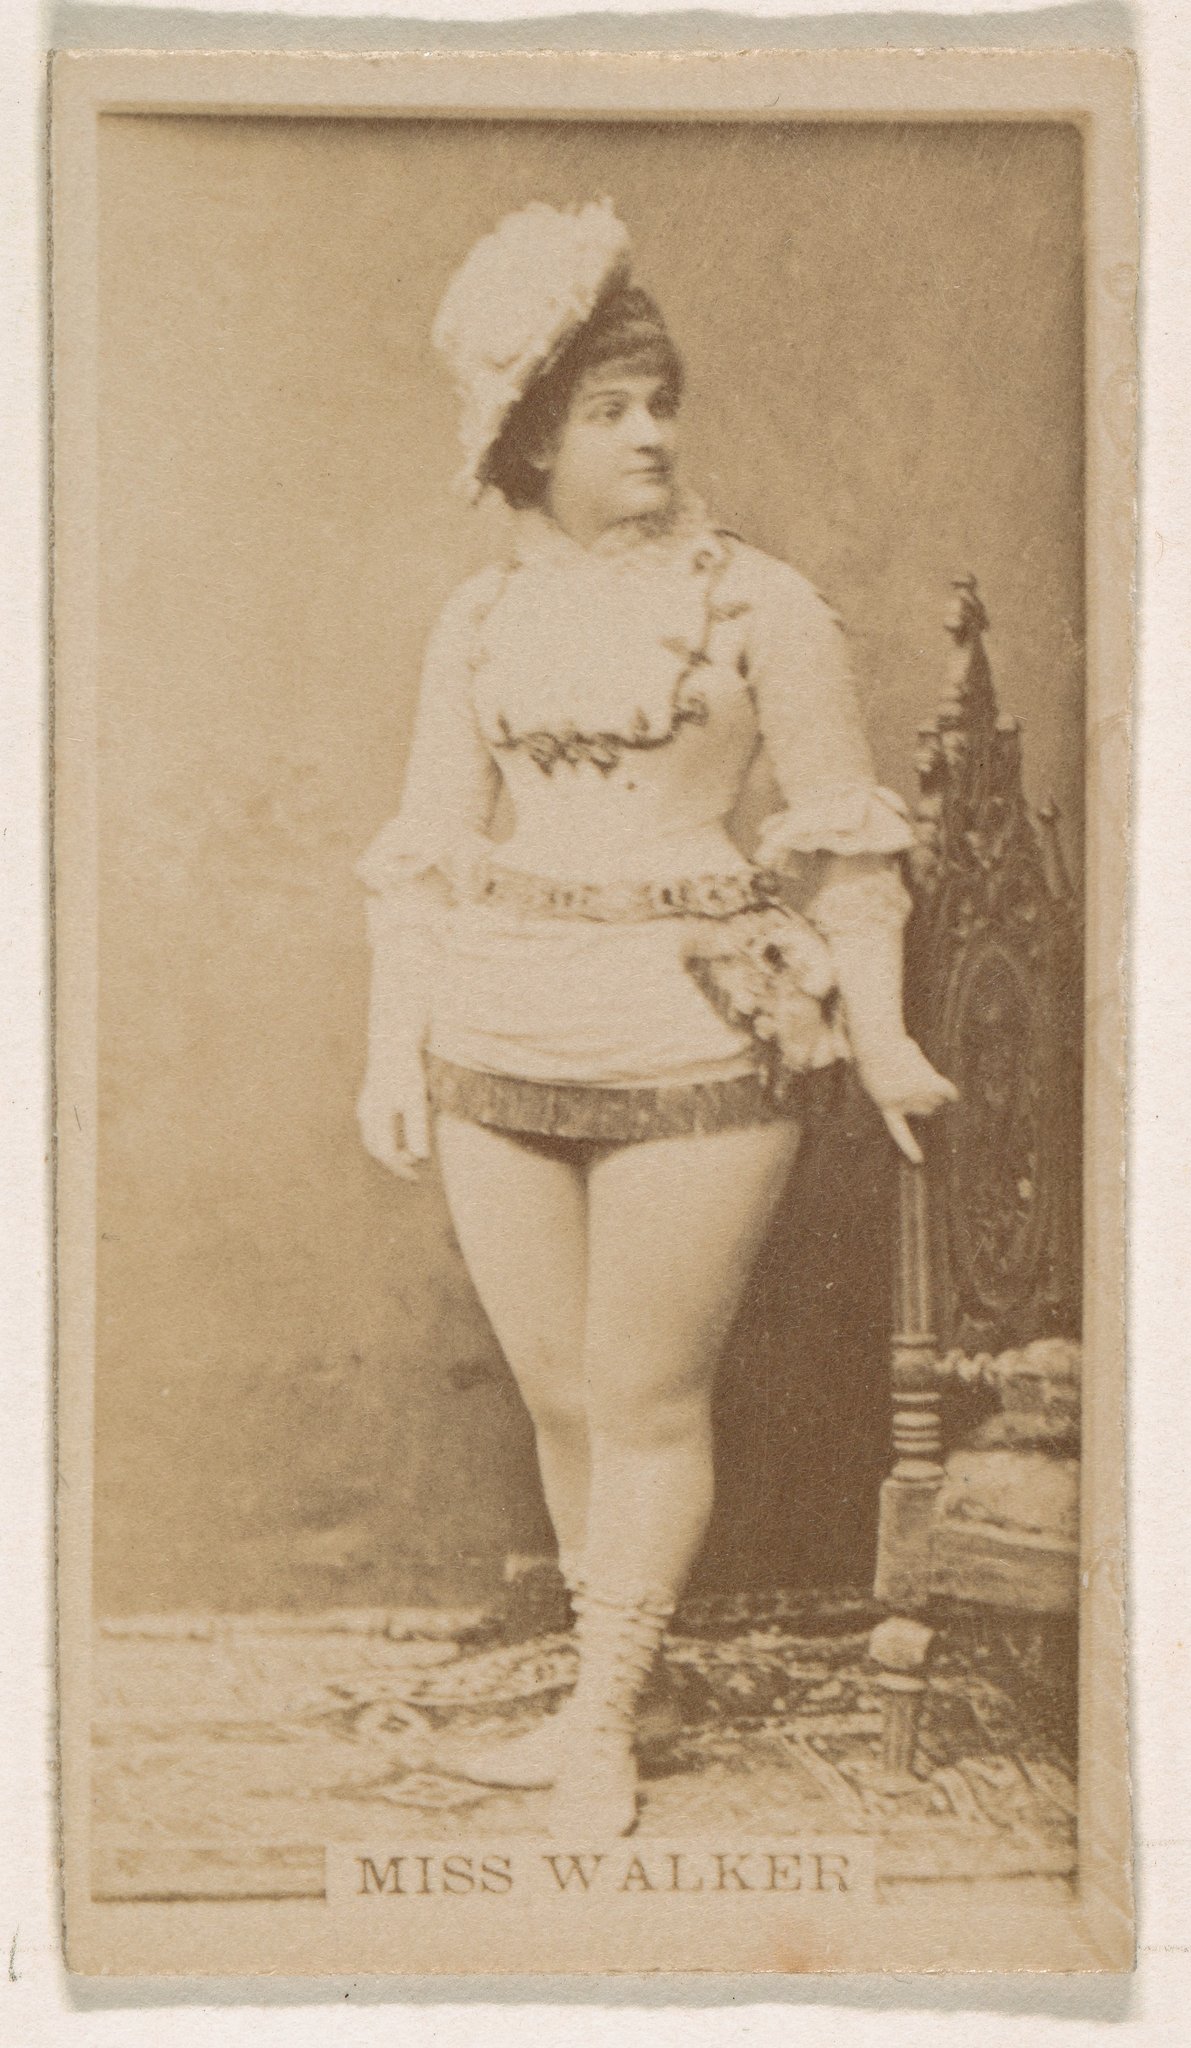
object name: photograph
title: Miss Walker, from the Actresses series (N245) issued by Kinney Brothers to promote Sweet Caporal Cigarettes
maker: kinney brothers tobacco company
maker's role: publisher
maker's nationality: american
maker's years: 1869-2011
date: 1890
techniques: albumen silver print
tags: portraits,women,actresses